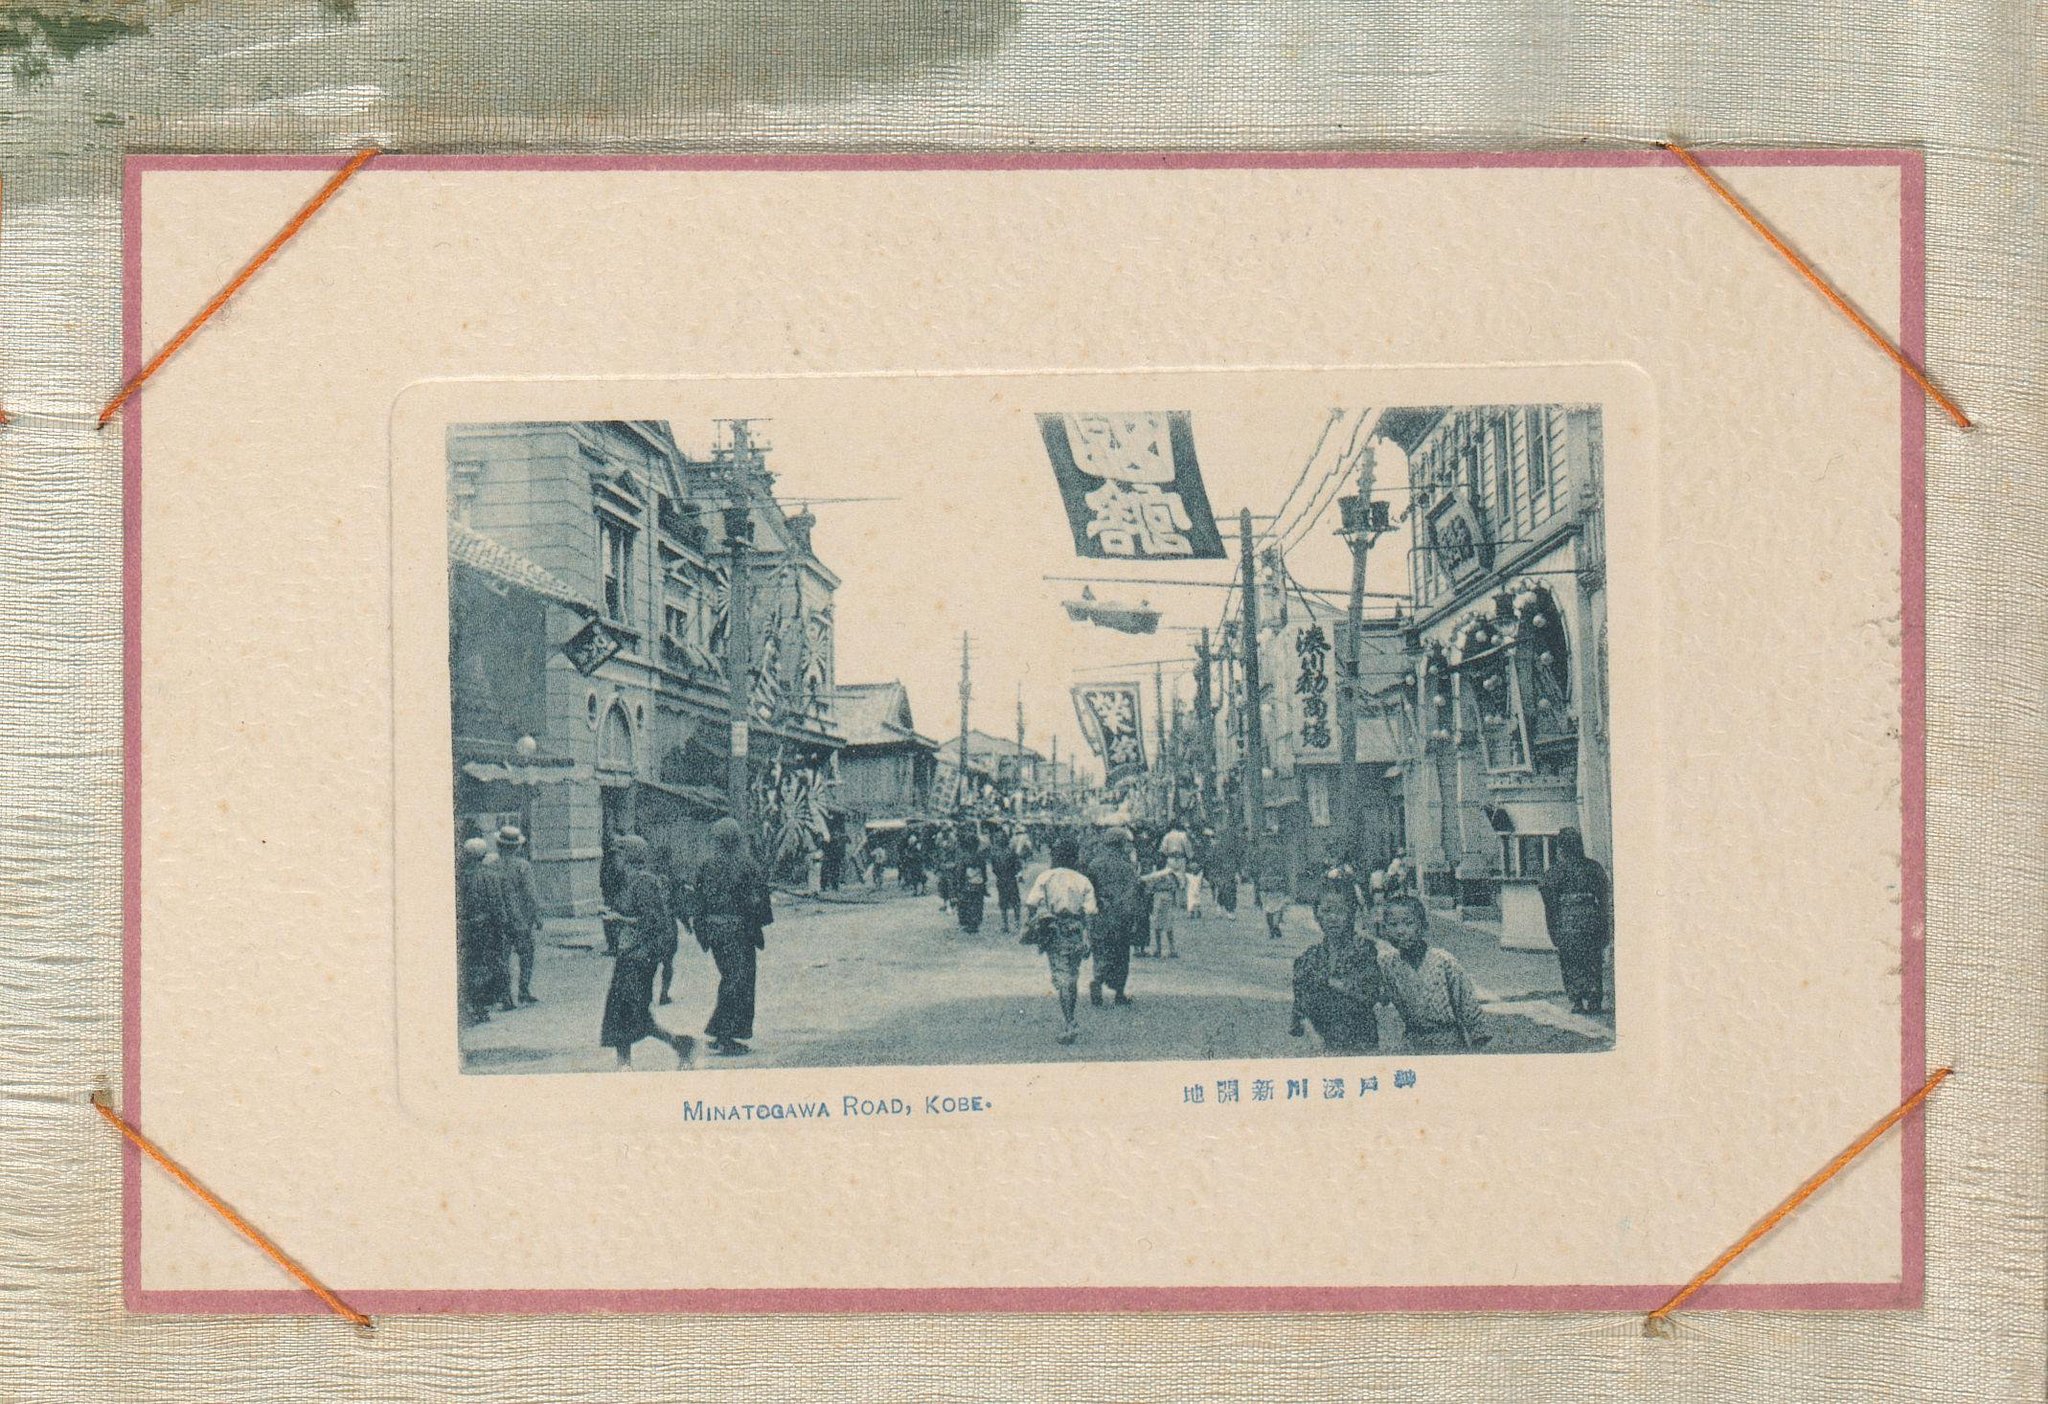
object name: photomechanical print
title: Gezicht op Minatogawa Road te Kobe, Japan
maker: Anonymous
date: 1900-1920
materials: paper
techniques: photograph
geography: kobe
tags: shop, store, street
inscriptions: title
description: Deze prent maakt deel uit van een album.